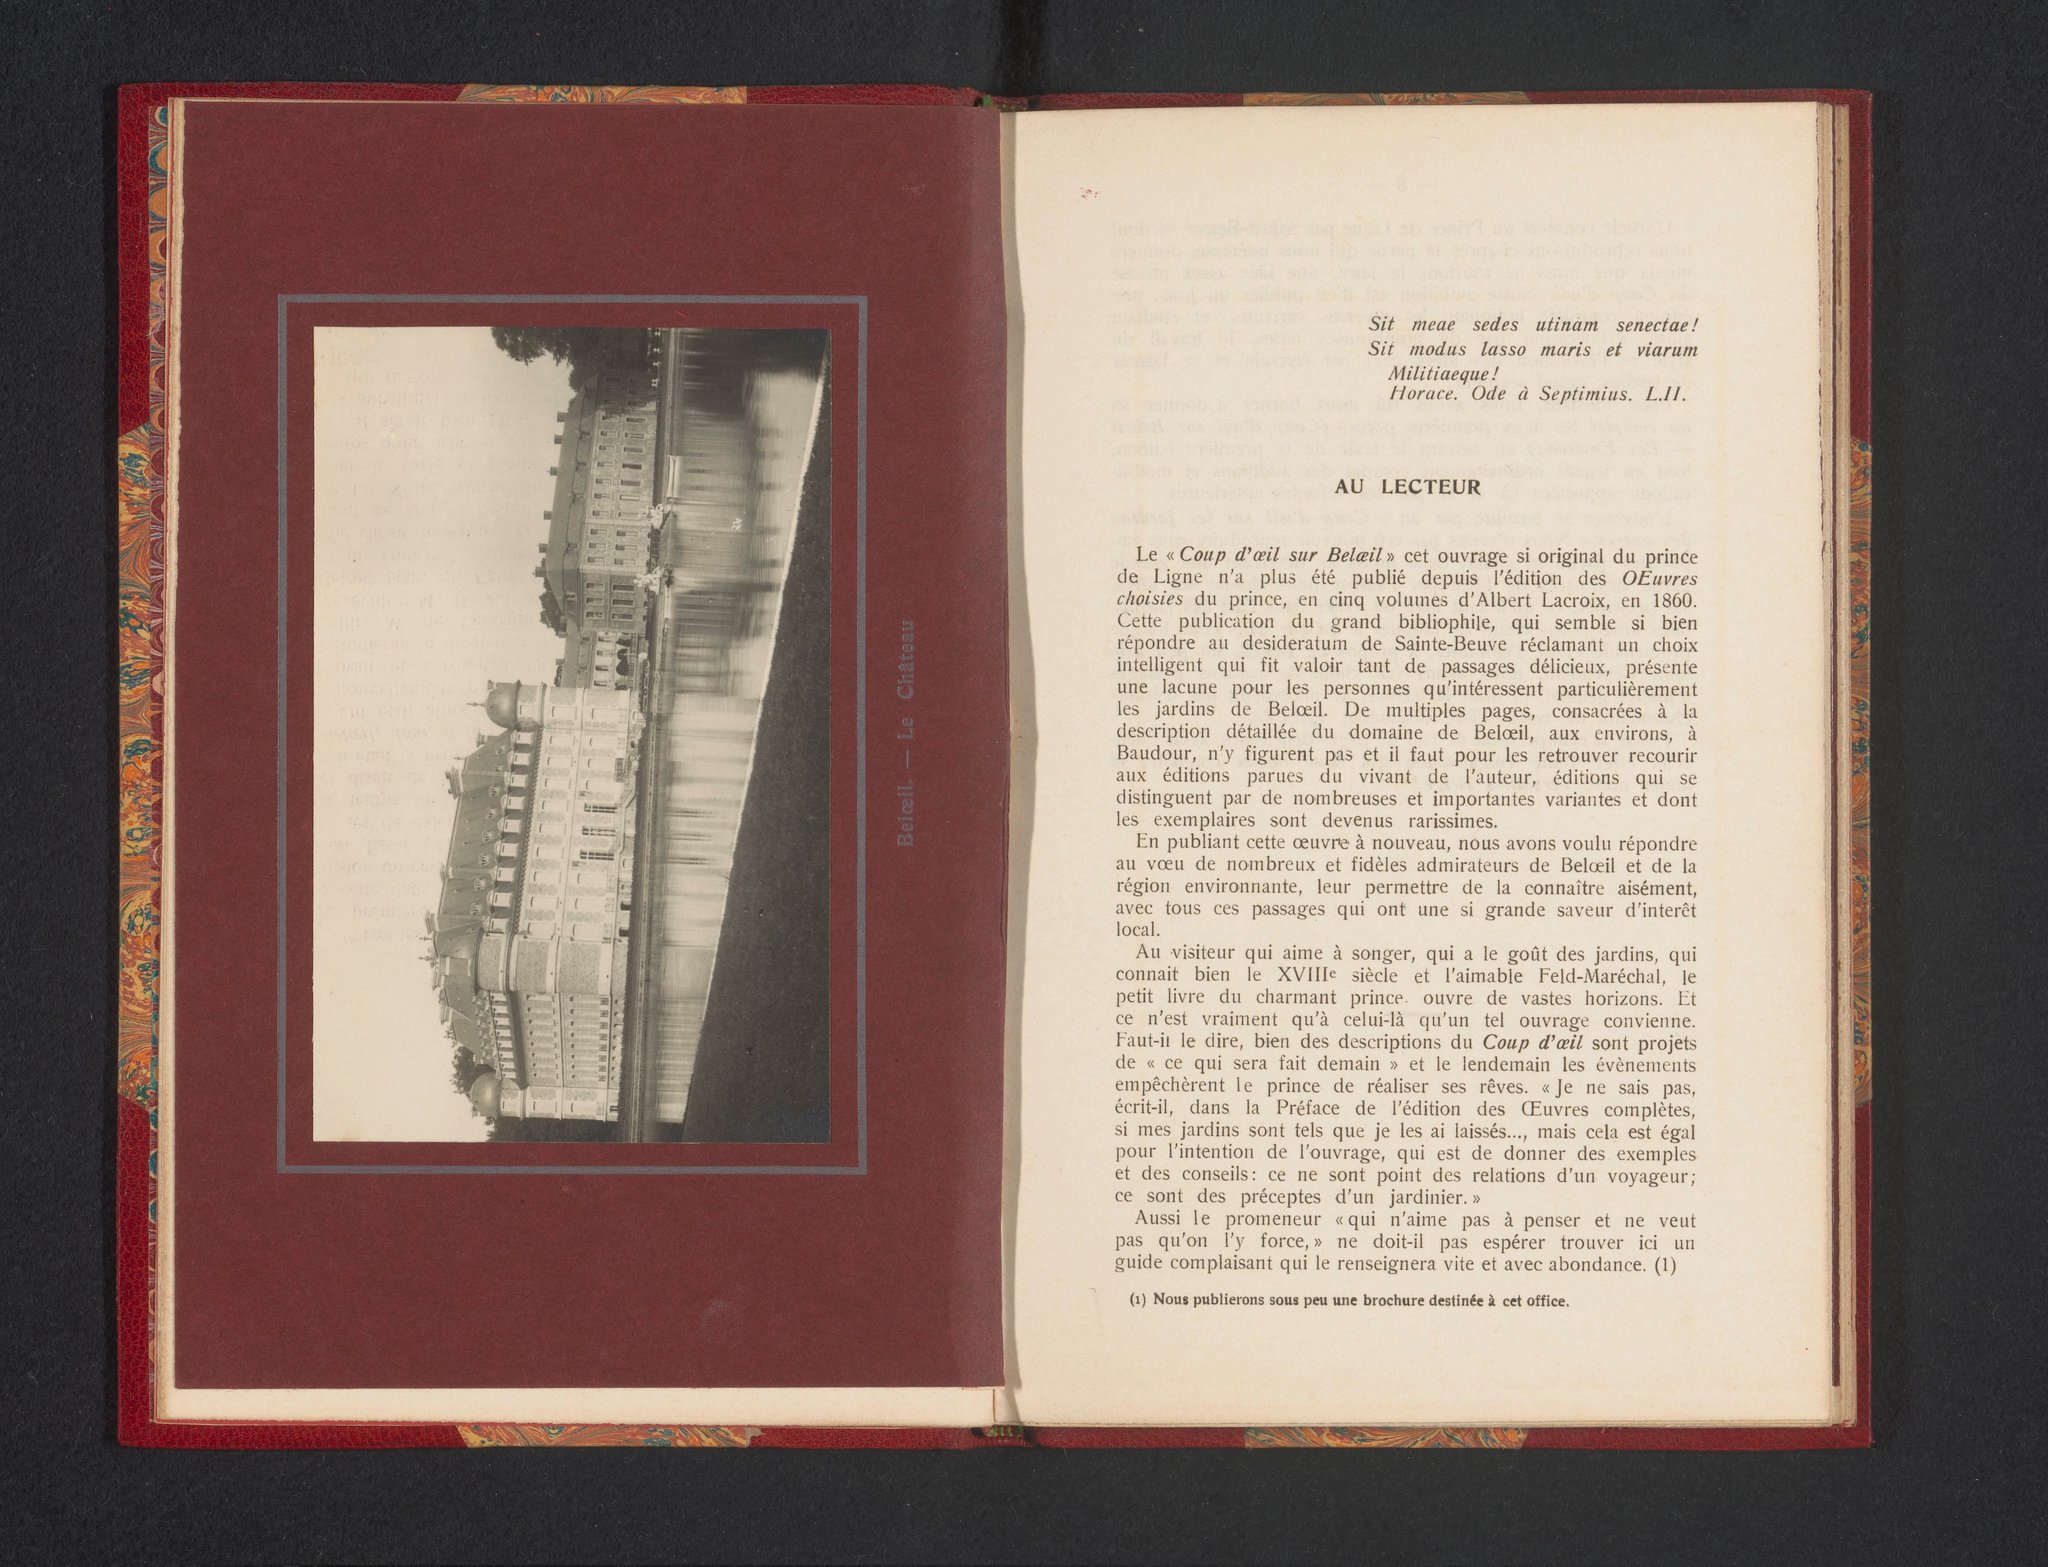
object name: page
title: Gezicht op het Château de Beloeil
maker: coppin-goisse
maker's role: printer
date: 1903-1908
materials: photographic support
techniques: gelatin silver print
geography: beloeil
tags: castle